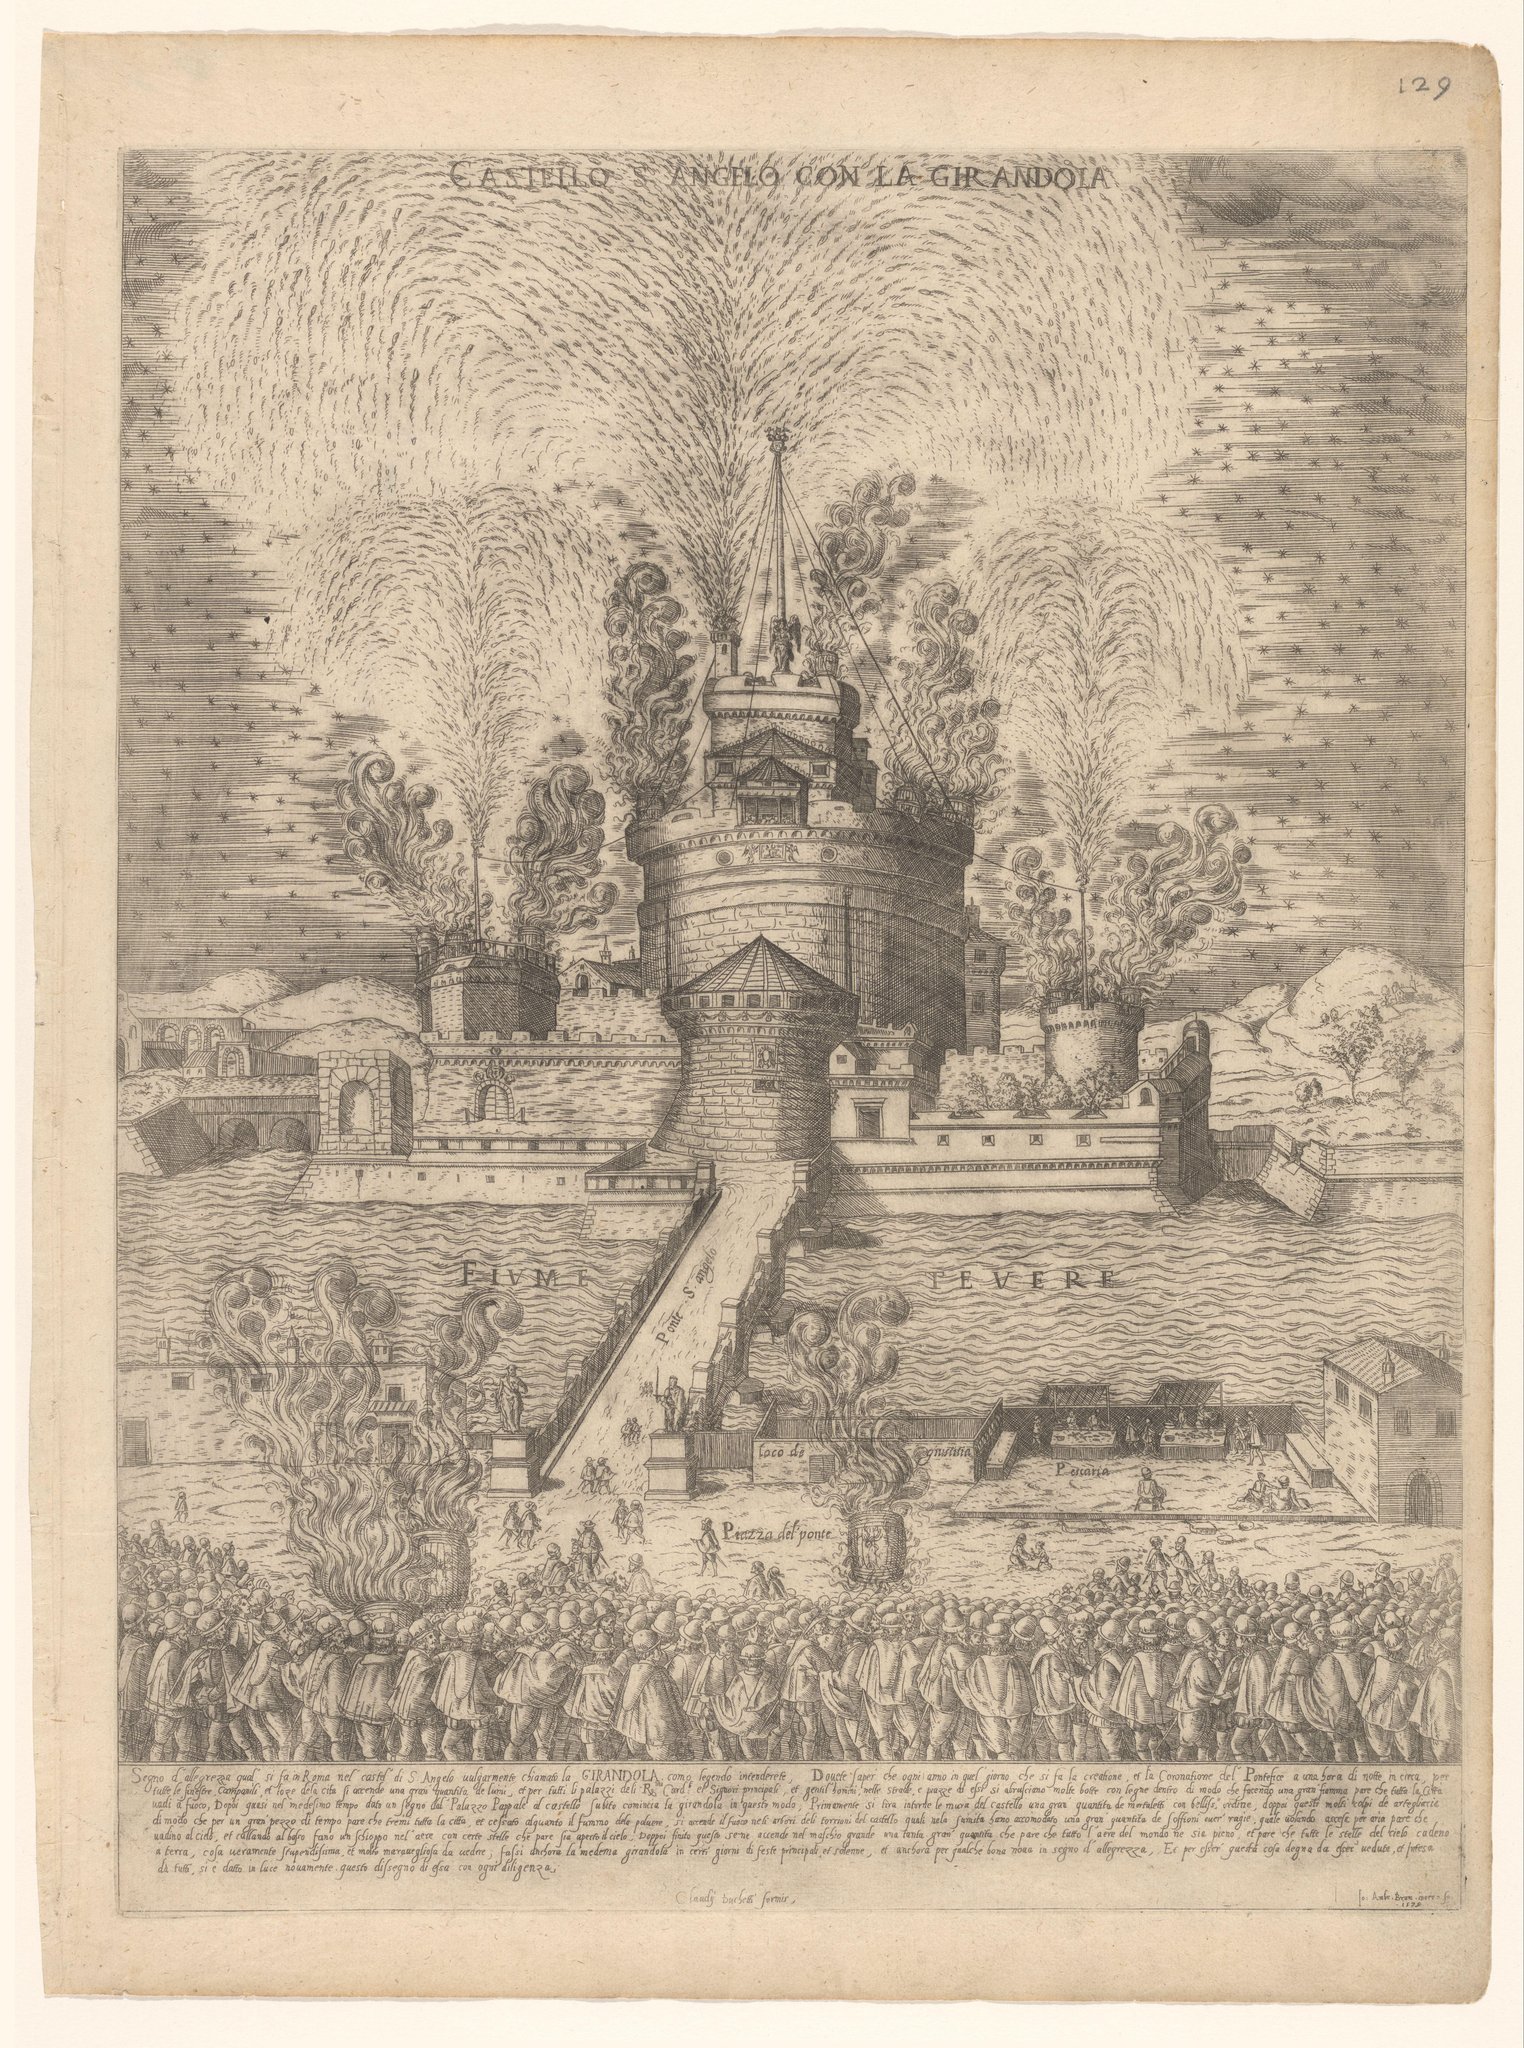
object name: print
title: Vuurwerk op de Engelenburcht in Rome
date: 1579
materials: paper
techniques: etching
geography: rome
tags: bonfire, fire-works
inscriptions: collector's mark: Lugt 2760, collector's mark: Lugt 2228